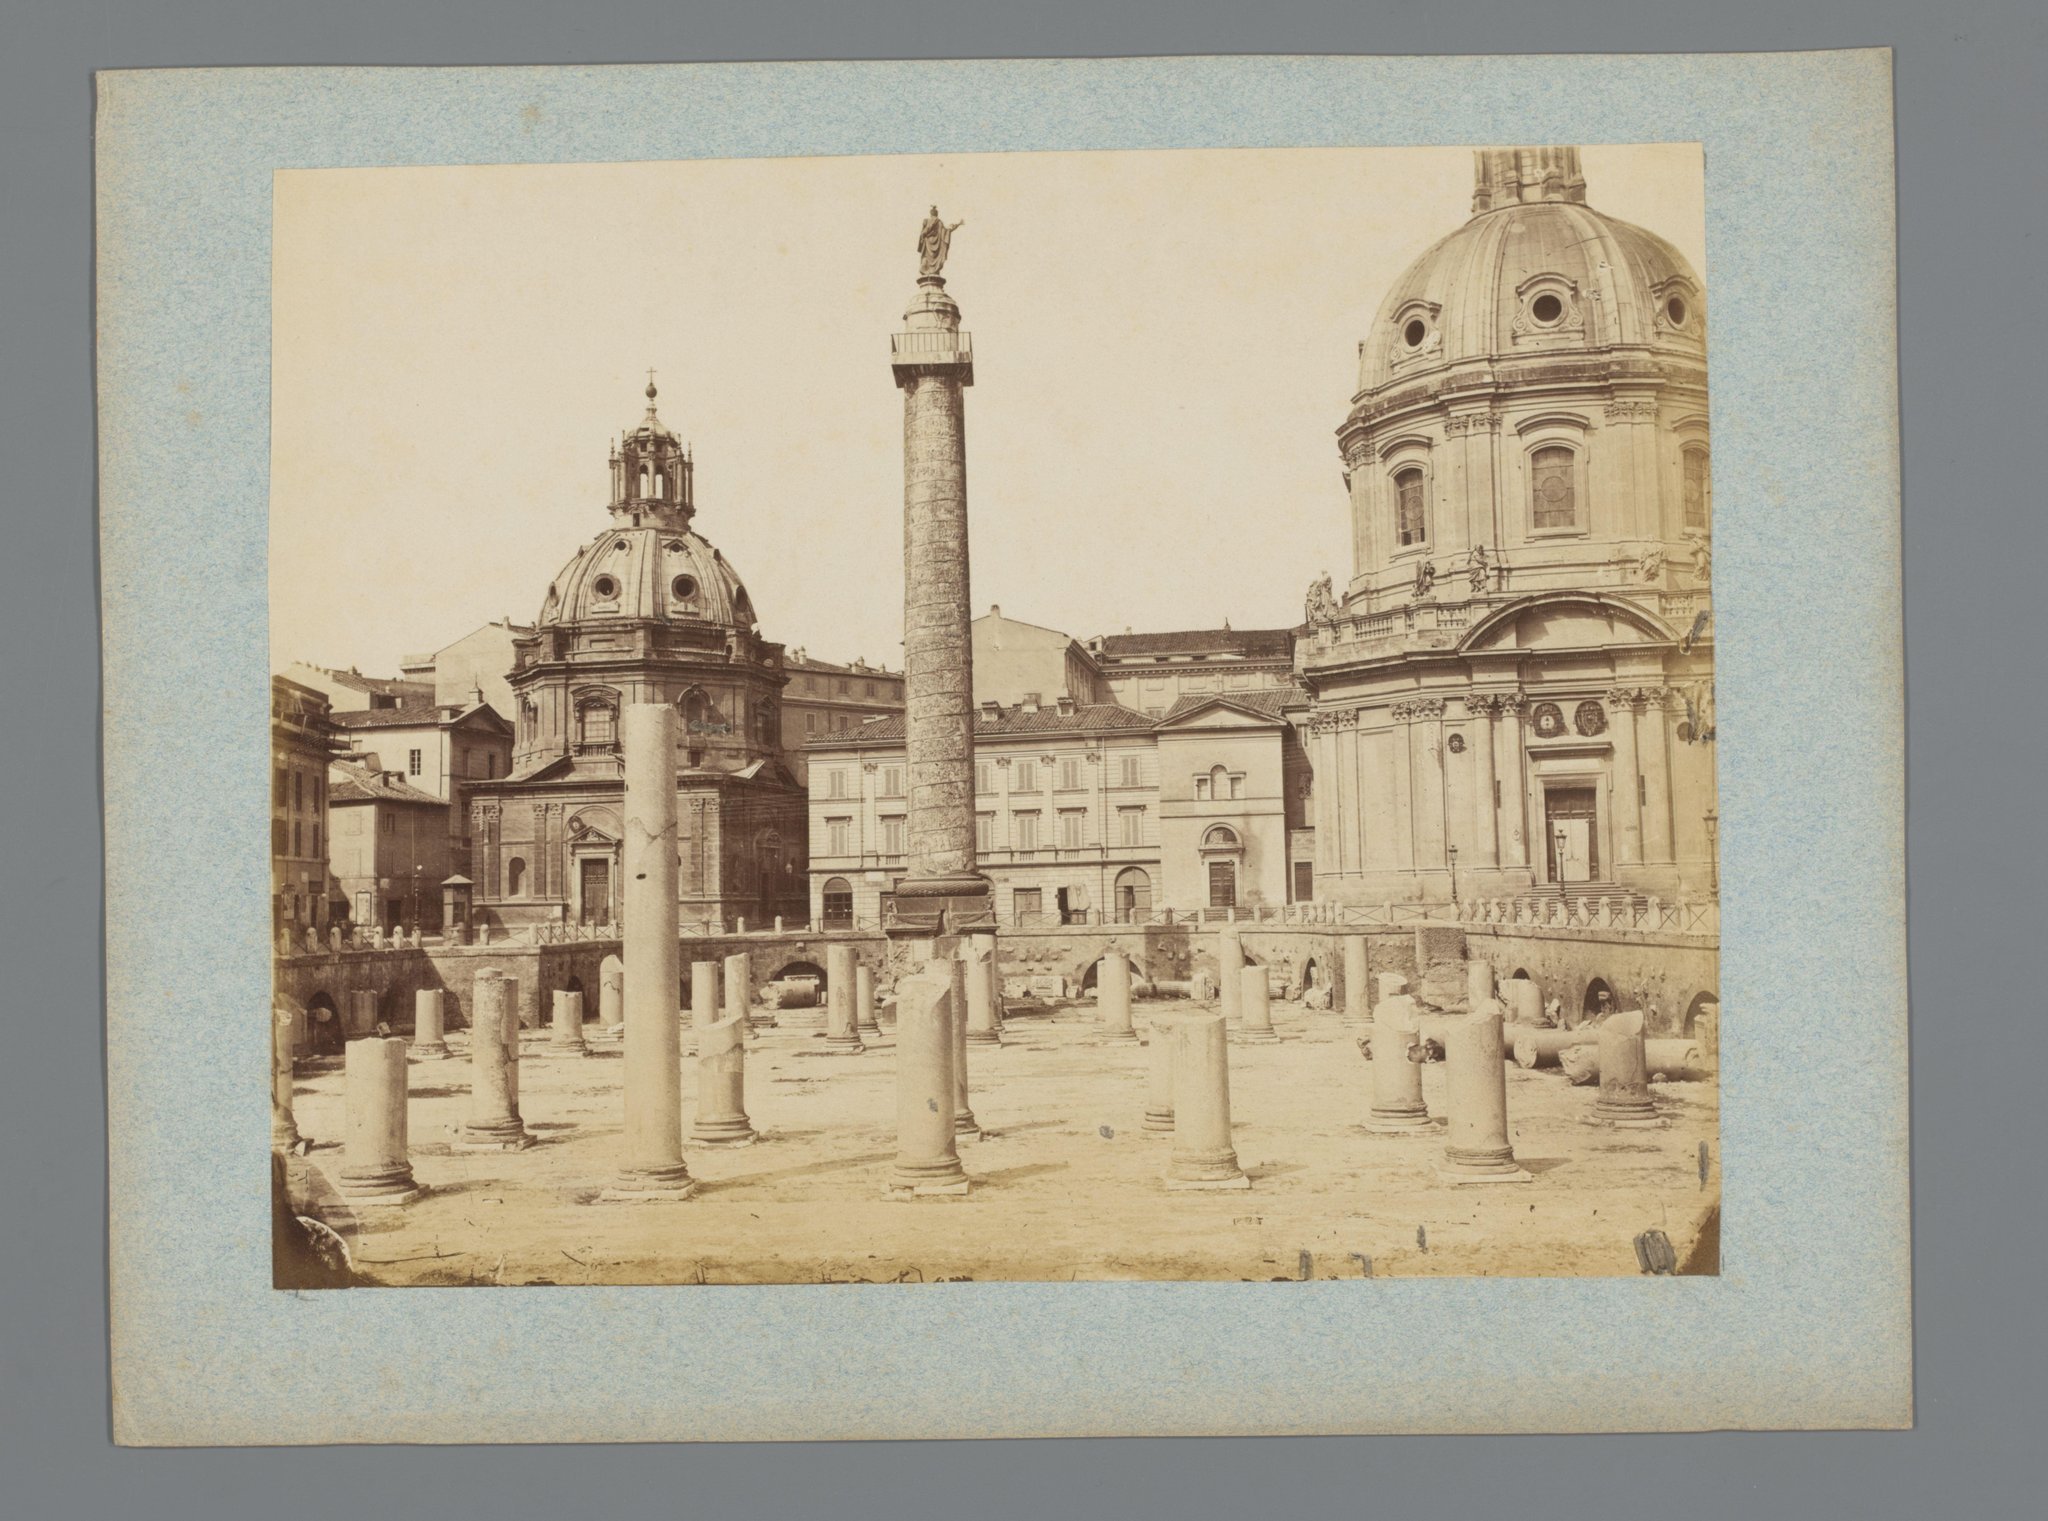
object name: photograph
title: Gezicht op het Forum van Trajanus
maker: Anonymous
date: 1851-1900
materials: cardboard, paper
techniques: albumen print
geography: forum of trajan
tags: ruin of a building ~ architecture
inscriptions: collector's mark: ‘VOSMAER’